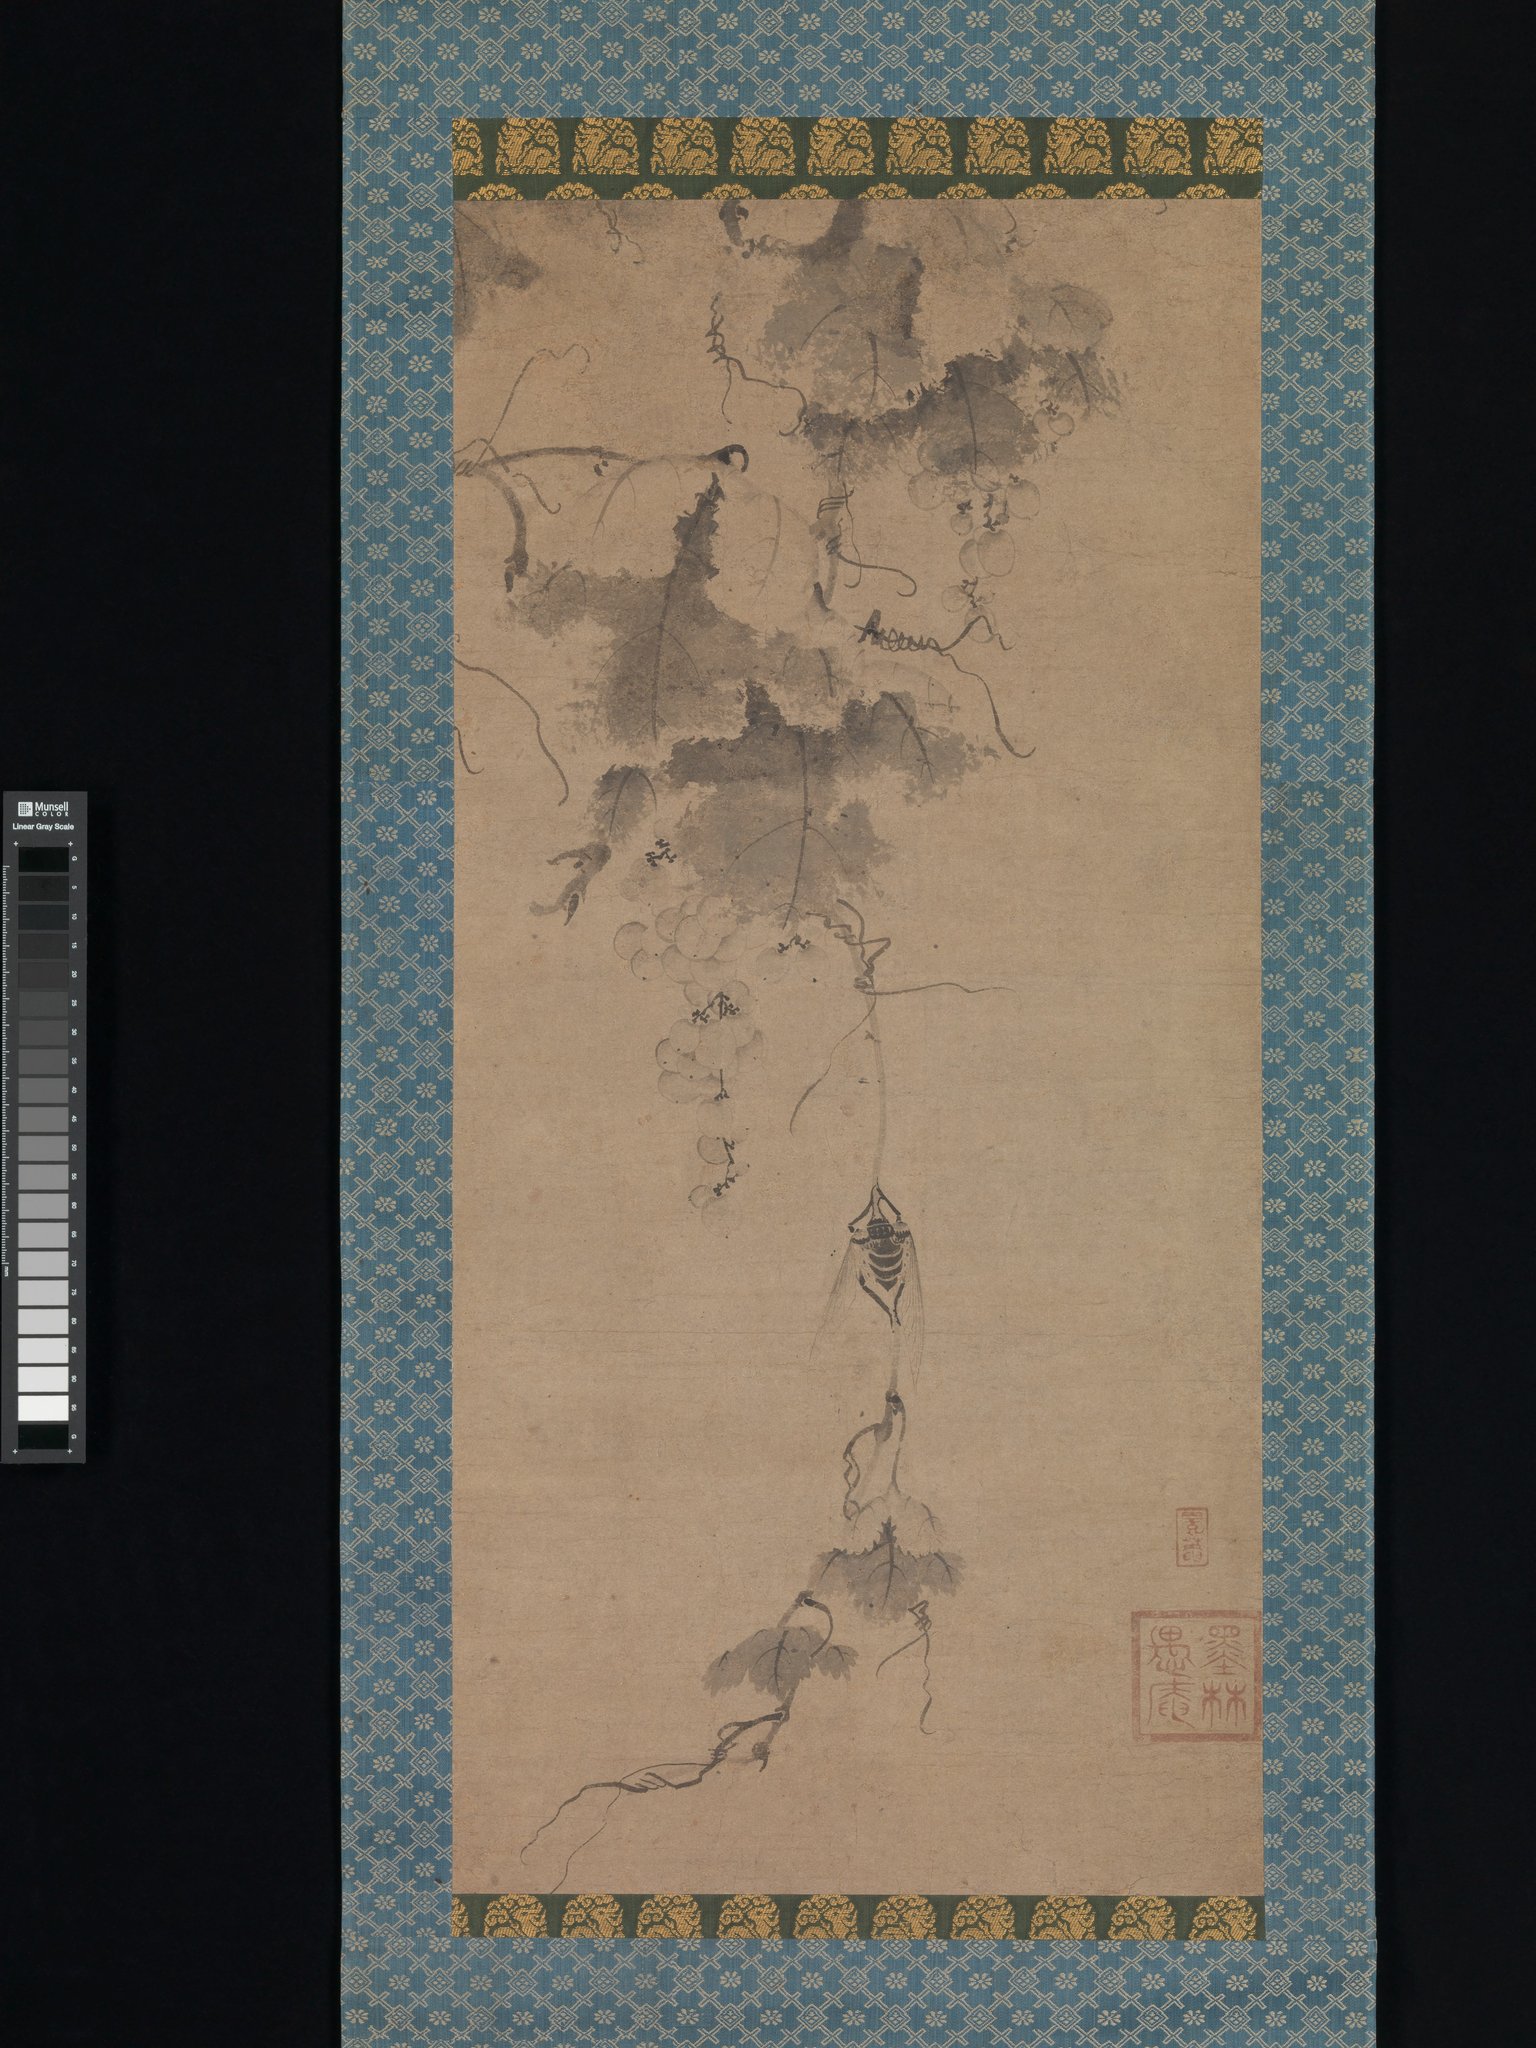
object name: hanging scroll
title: Cicada on a Grapevine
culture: japanese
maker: bokurin guan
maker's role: artist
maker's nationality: japanese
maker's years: 1367-1399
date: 1367-1433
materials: ink, paper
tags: insects,vines